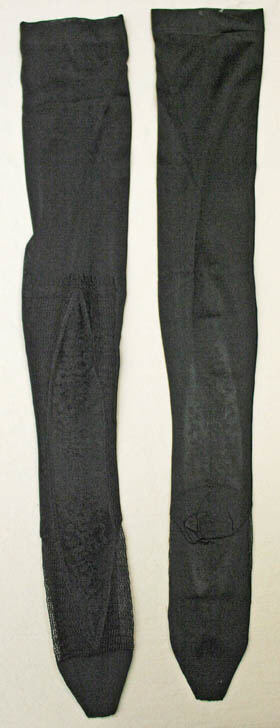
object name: stocking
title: Stockings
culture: french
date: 1801-1900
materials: silk